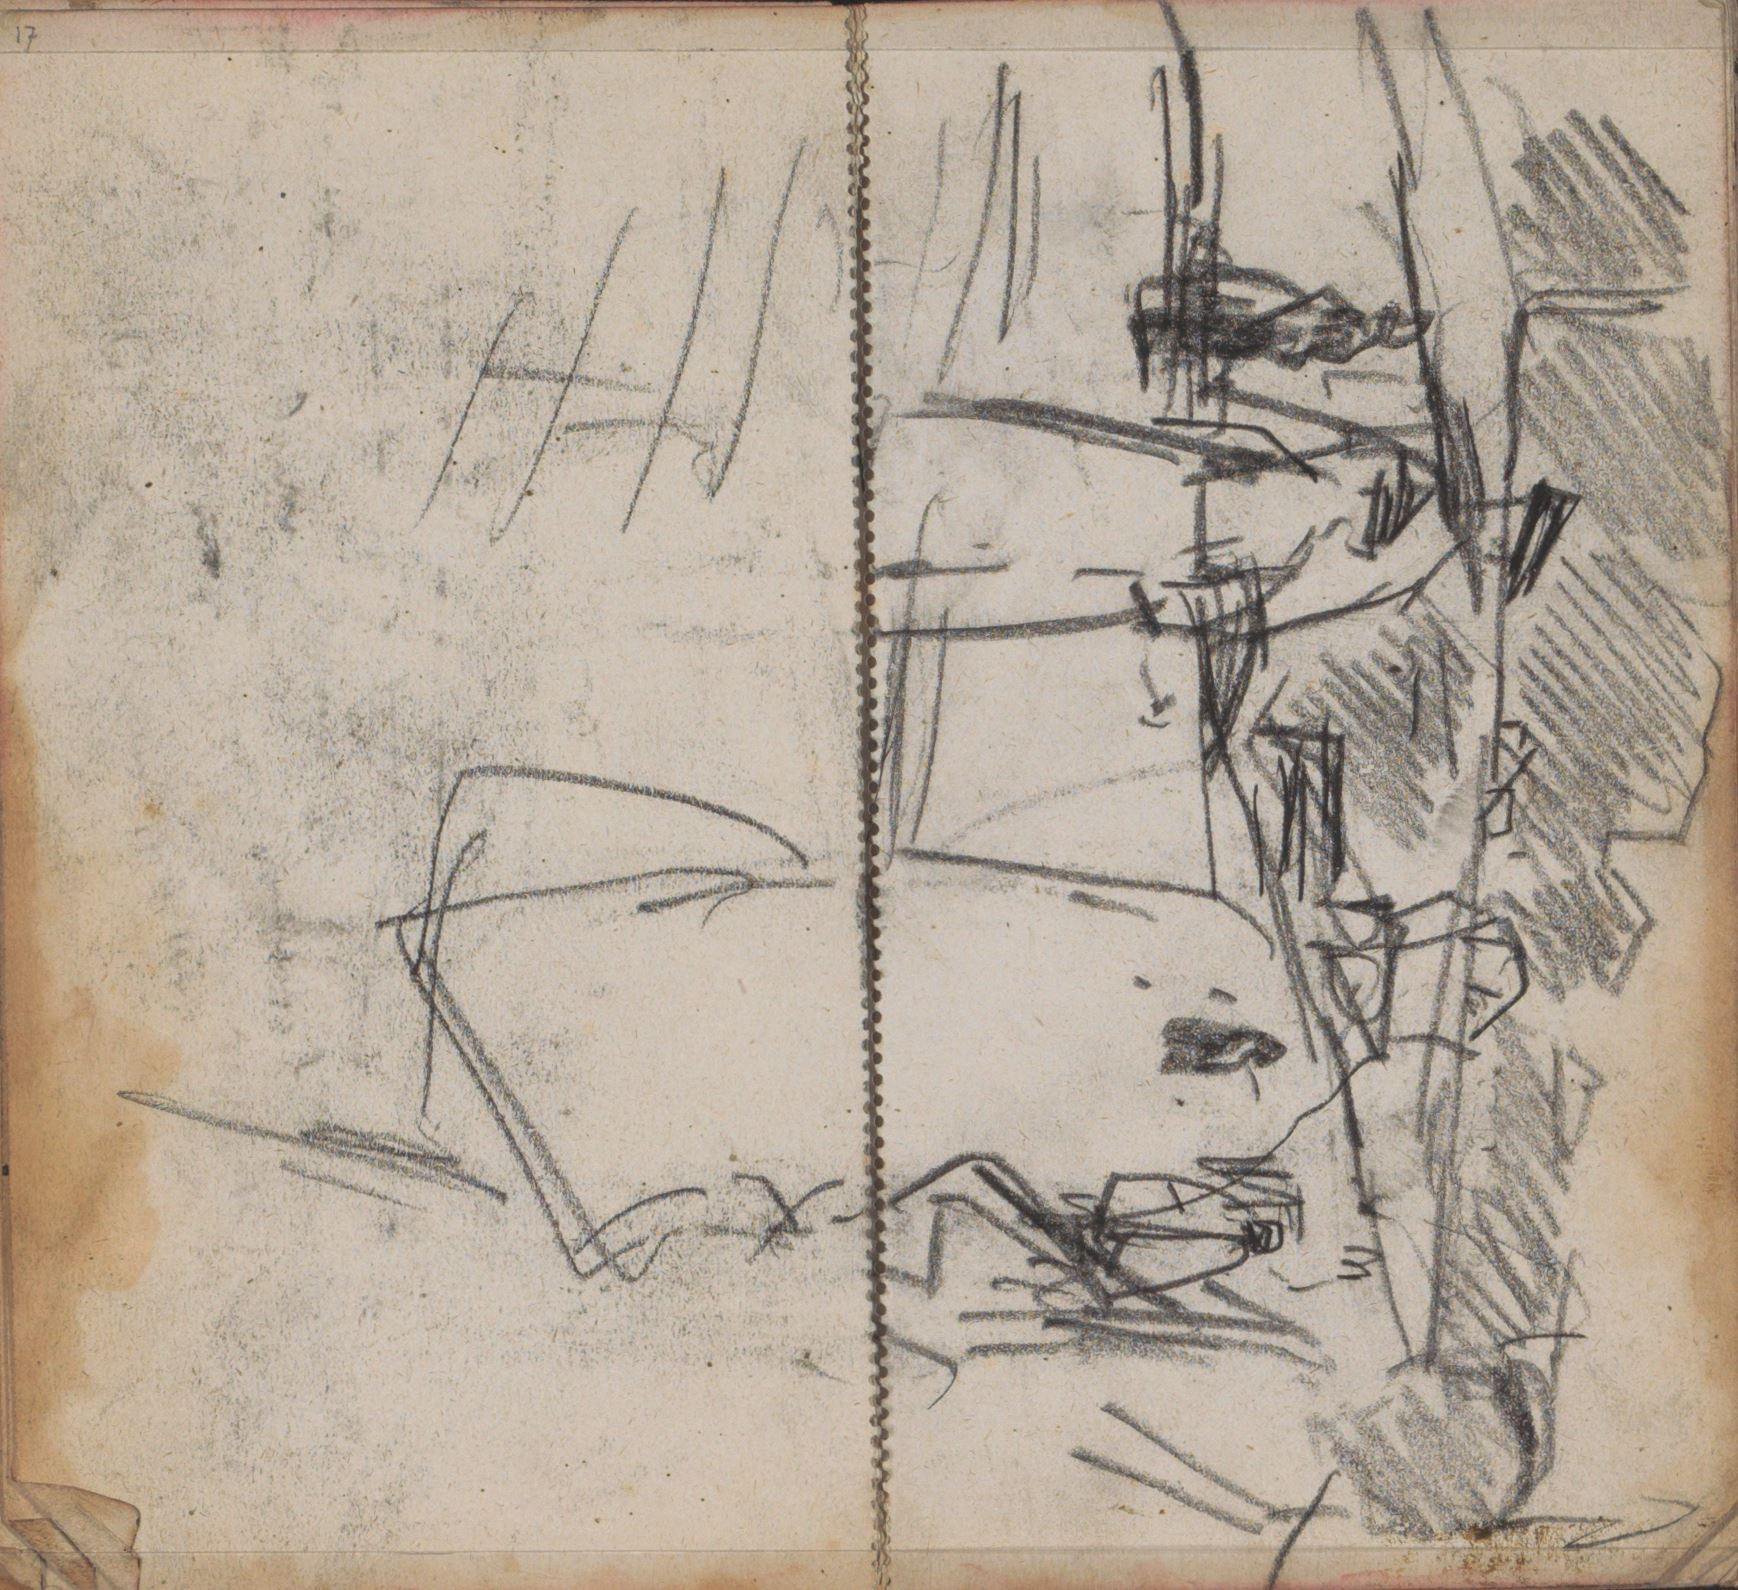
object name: sketchbook leaf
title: Stadsgezicht met figuren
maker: george hendrik breitner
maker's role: draughtsman, painter, print maker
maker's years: 1857-1923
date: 1893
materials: chalk, paper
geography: amsterdam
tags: city-view, and landscape with man-made constructions (+ city(-scape) with figures, staffage), amsterdam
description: Stadsgezicht, waarschijnlijk een gezicht in Amsterdam, met figuren. Pagina 17 en pagina 18 uit een schetsboek met 22 bladen vervaardigd te Amsterdam.